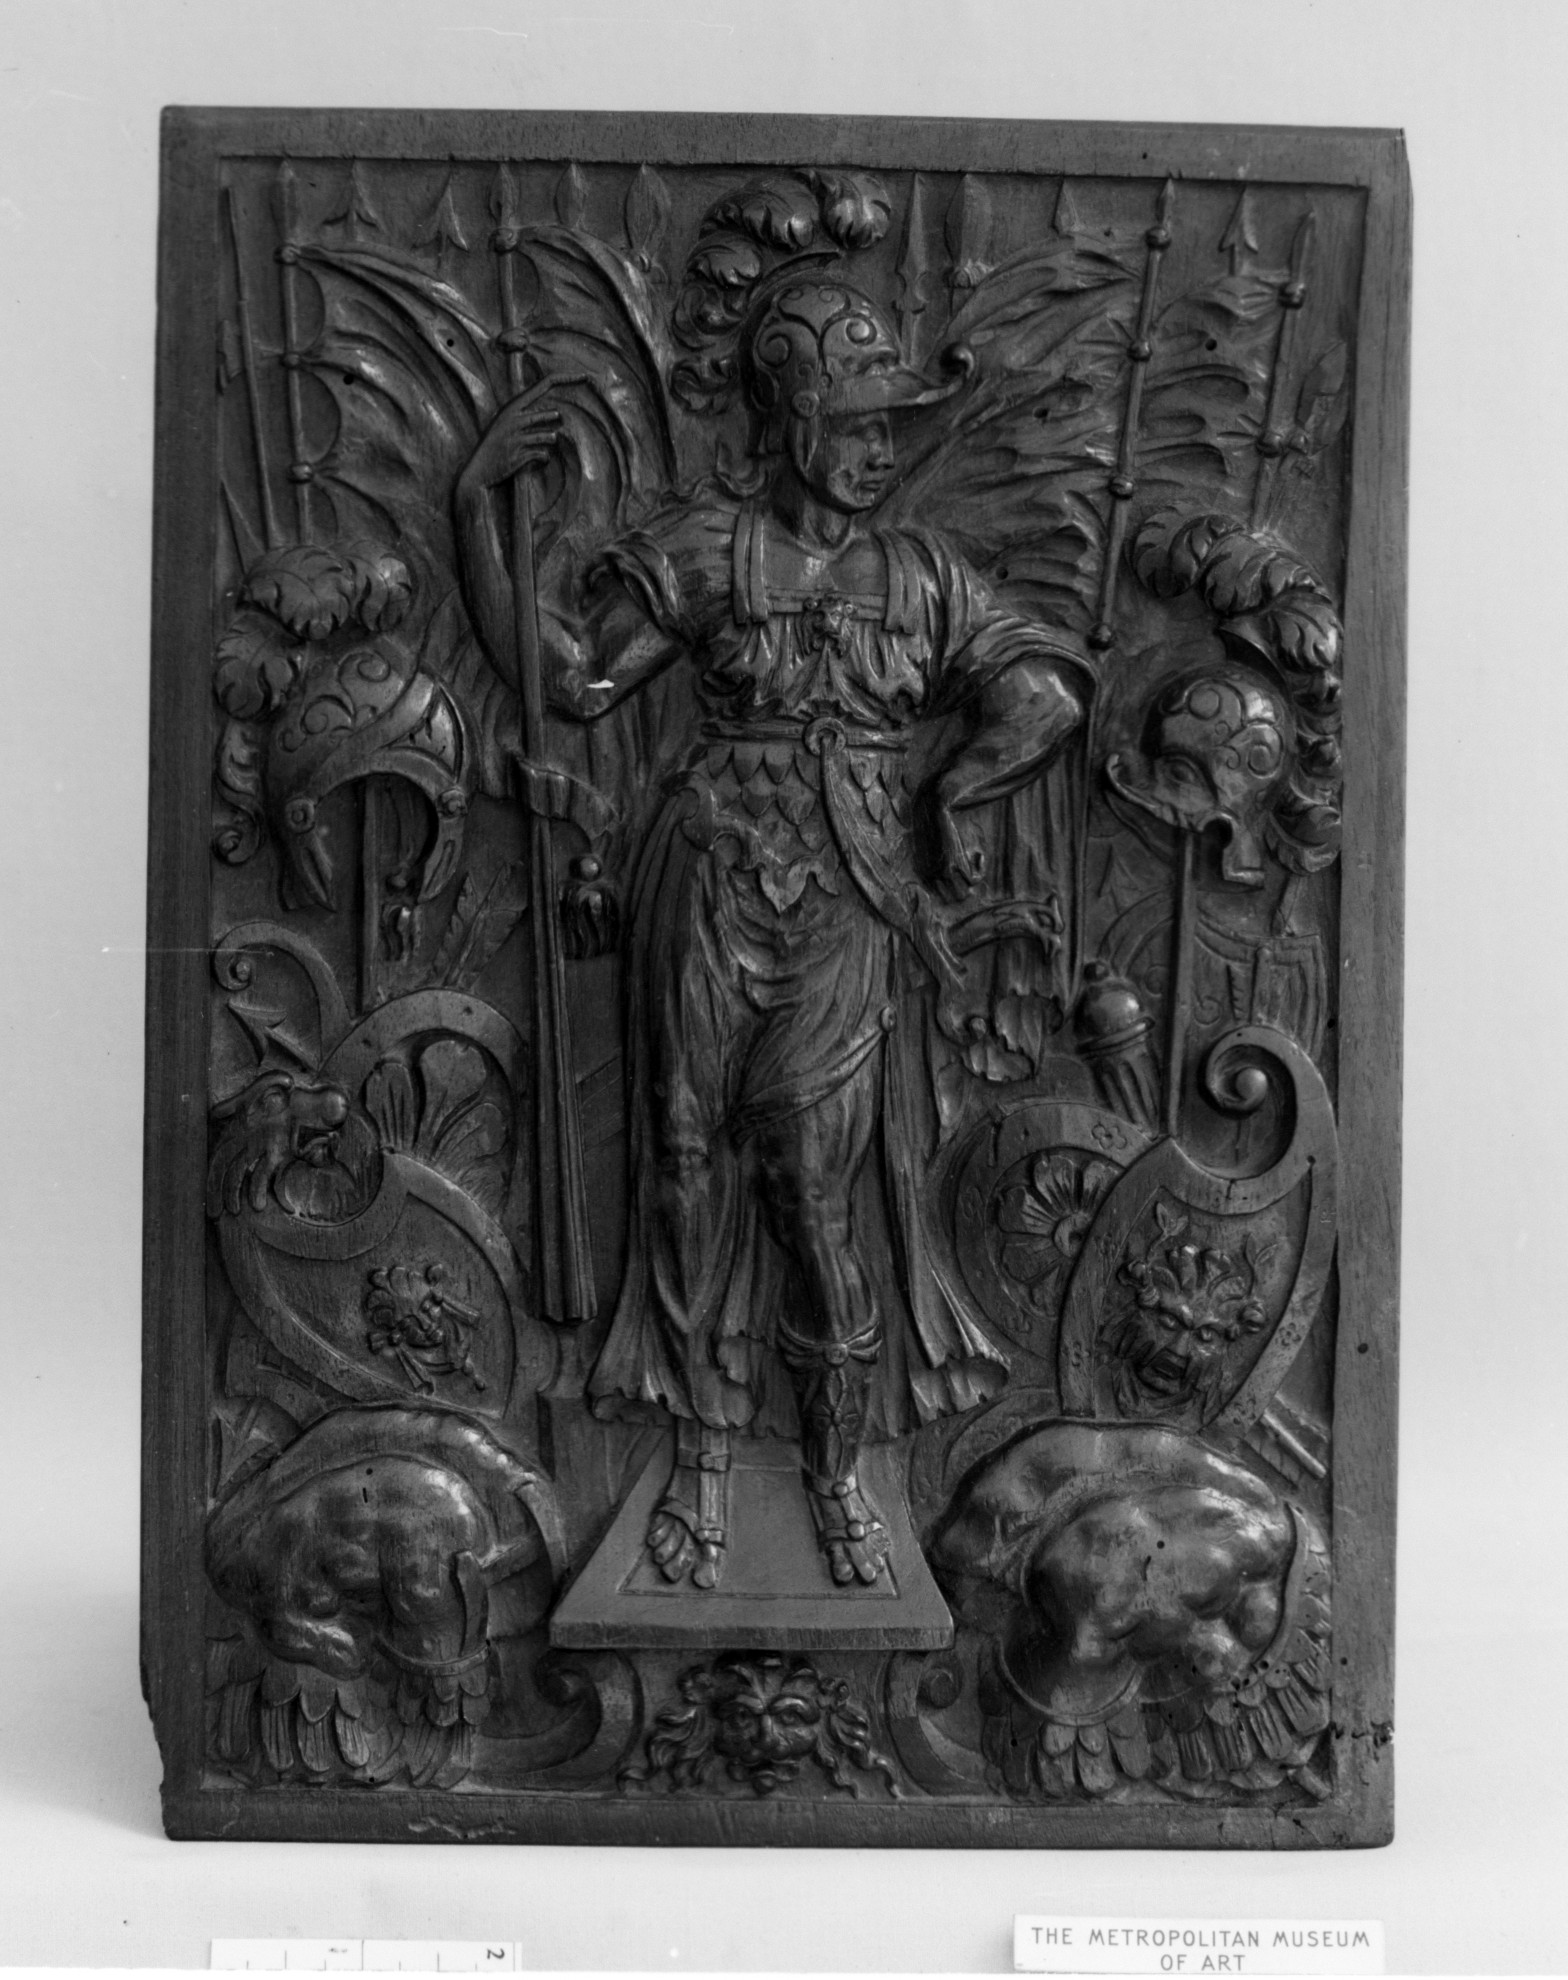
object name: panel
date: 1501-1600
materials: wood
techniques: carving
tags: soldiers,spears